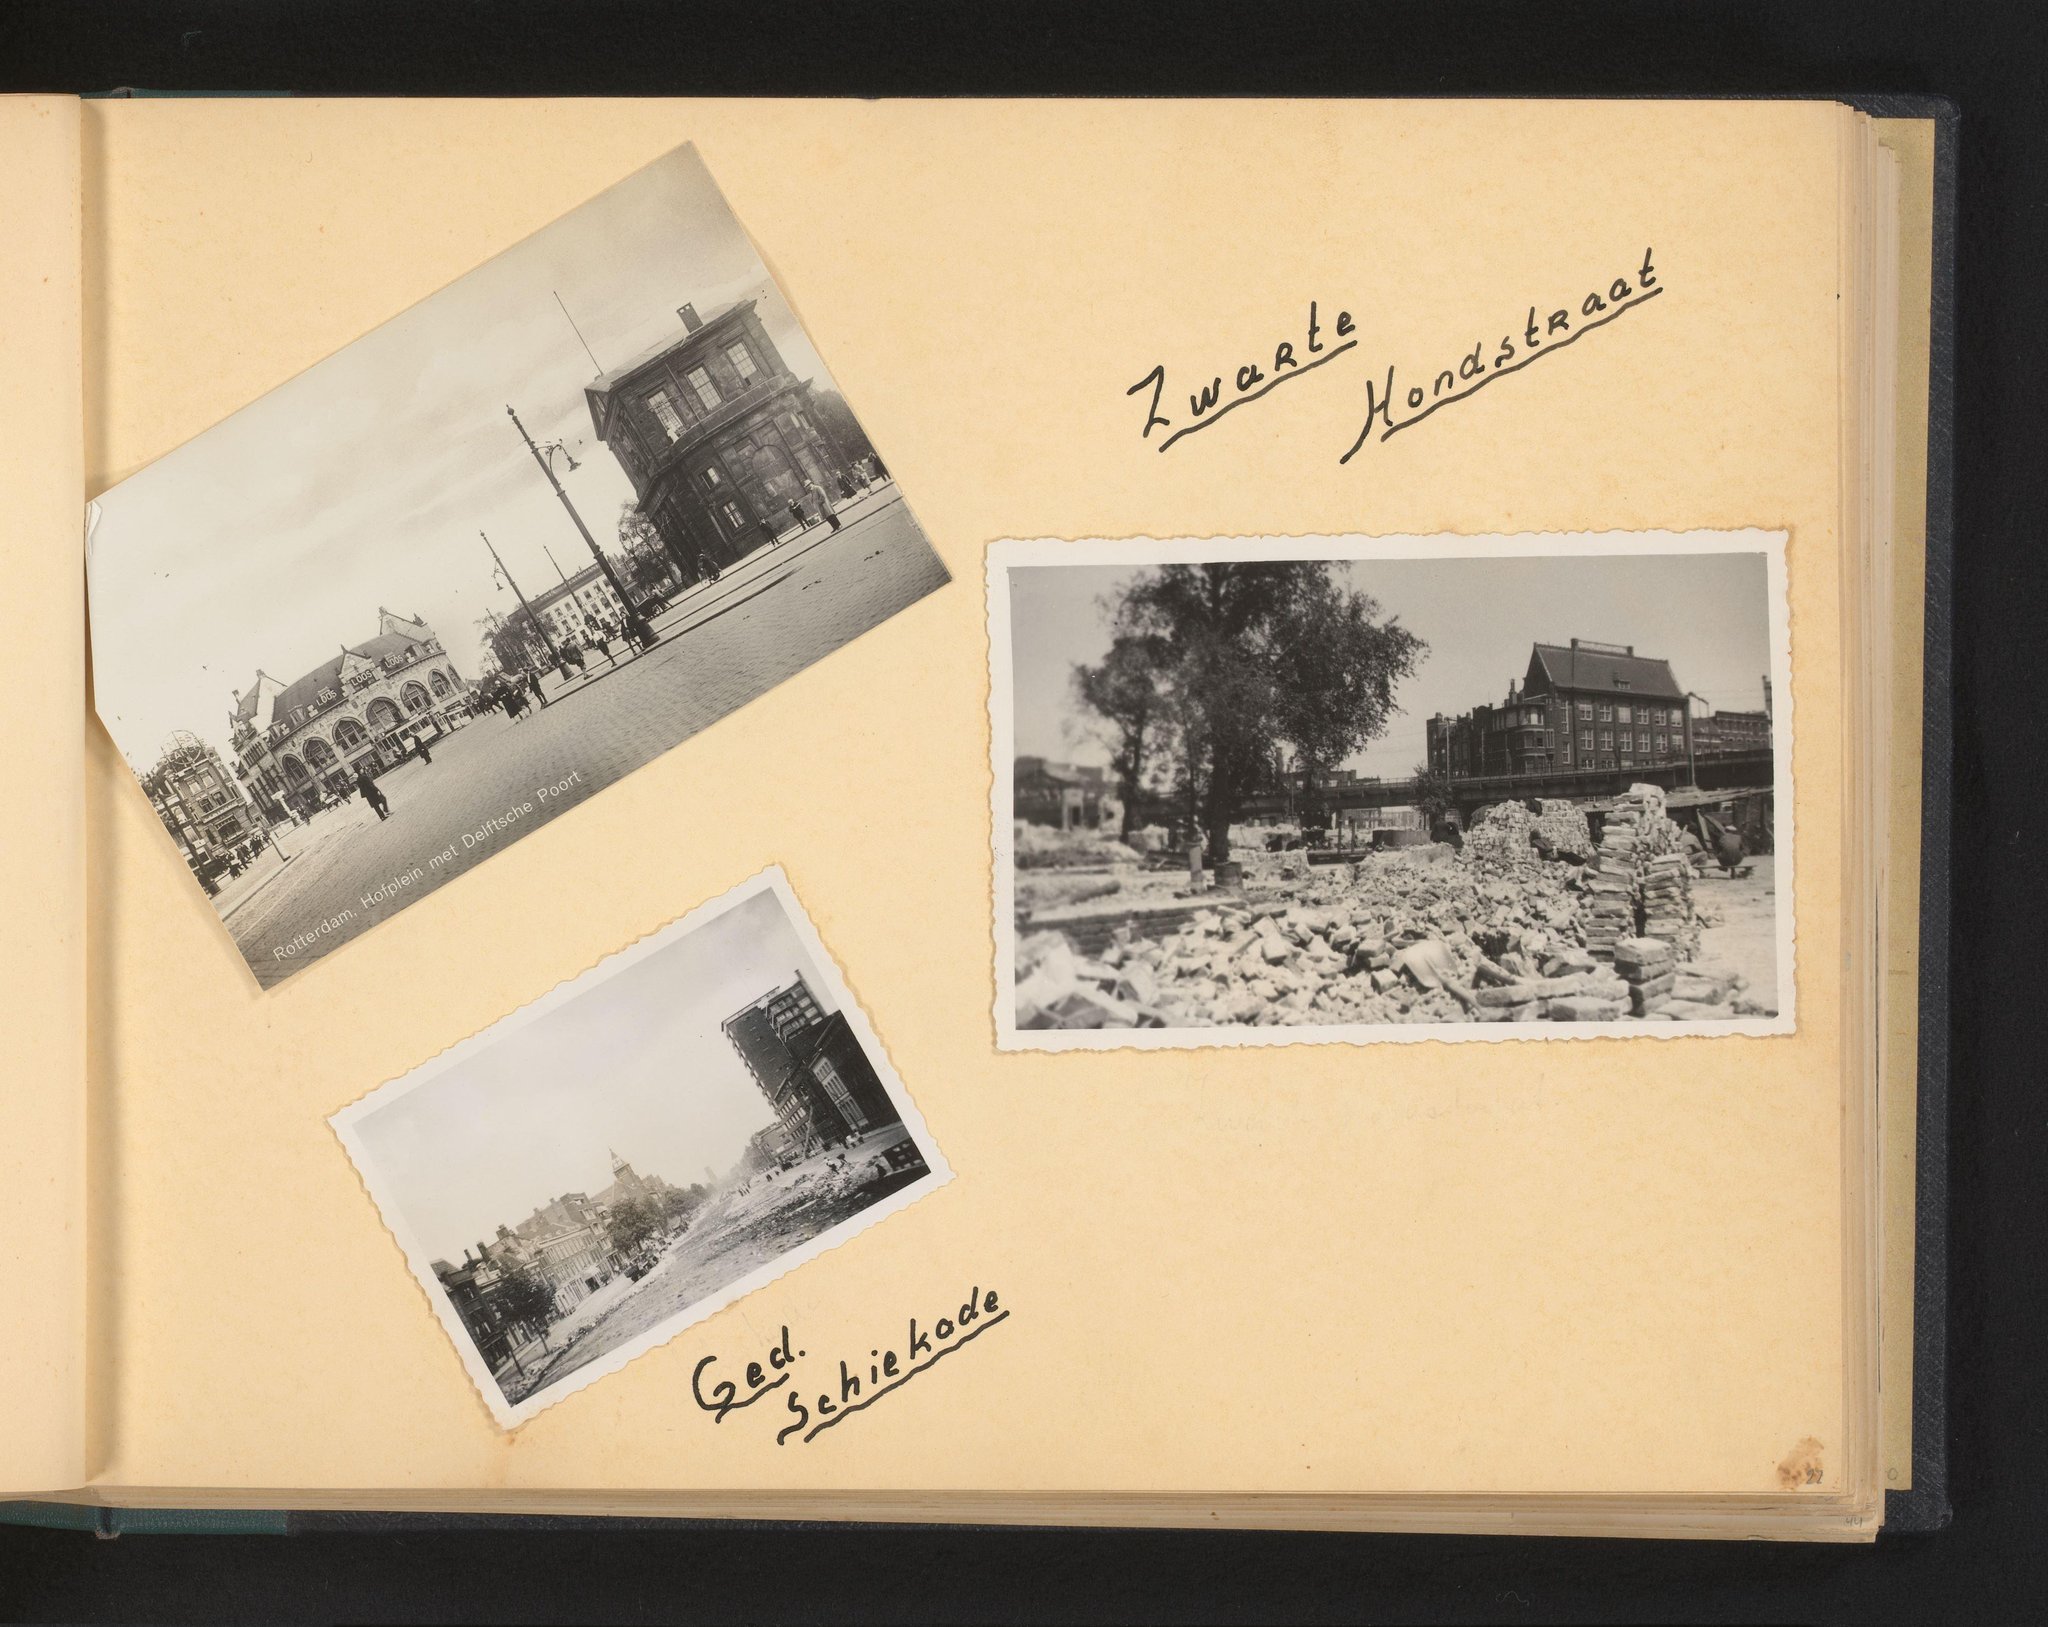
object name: photograph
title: Zwarte Hondstraat / Ged. Schiekade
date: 1940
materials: cardboard, photographic support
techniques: gelatin silver print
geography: rotterdam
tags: non-combatants ~ war, devastated, ruined place or city (~ warfare), rotterdam, rotterdam blitz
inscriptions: inscription: ‘Zwarte Hondstraat / Ged. Schiekade’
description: Albumblad met twee prentbriefkaarten en een foto van de Zwarte Hondstraat en de Gedempte Schiekade te Rotterdam, voor en na het bombardement. Onderdeel van het fotoalbum over de verwoestingen van Nederlandse steden en infrastructuur in het begin van de Tweede Wereldoorlog.